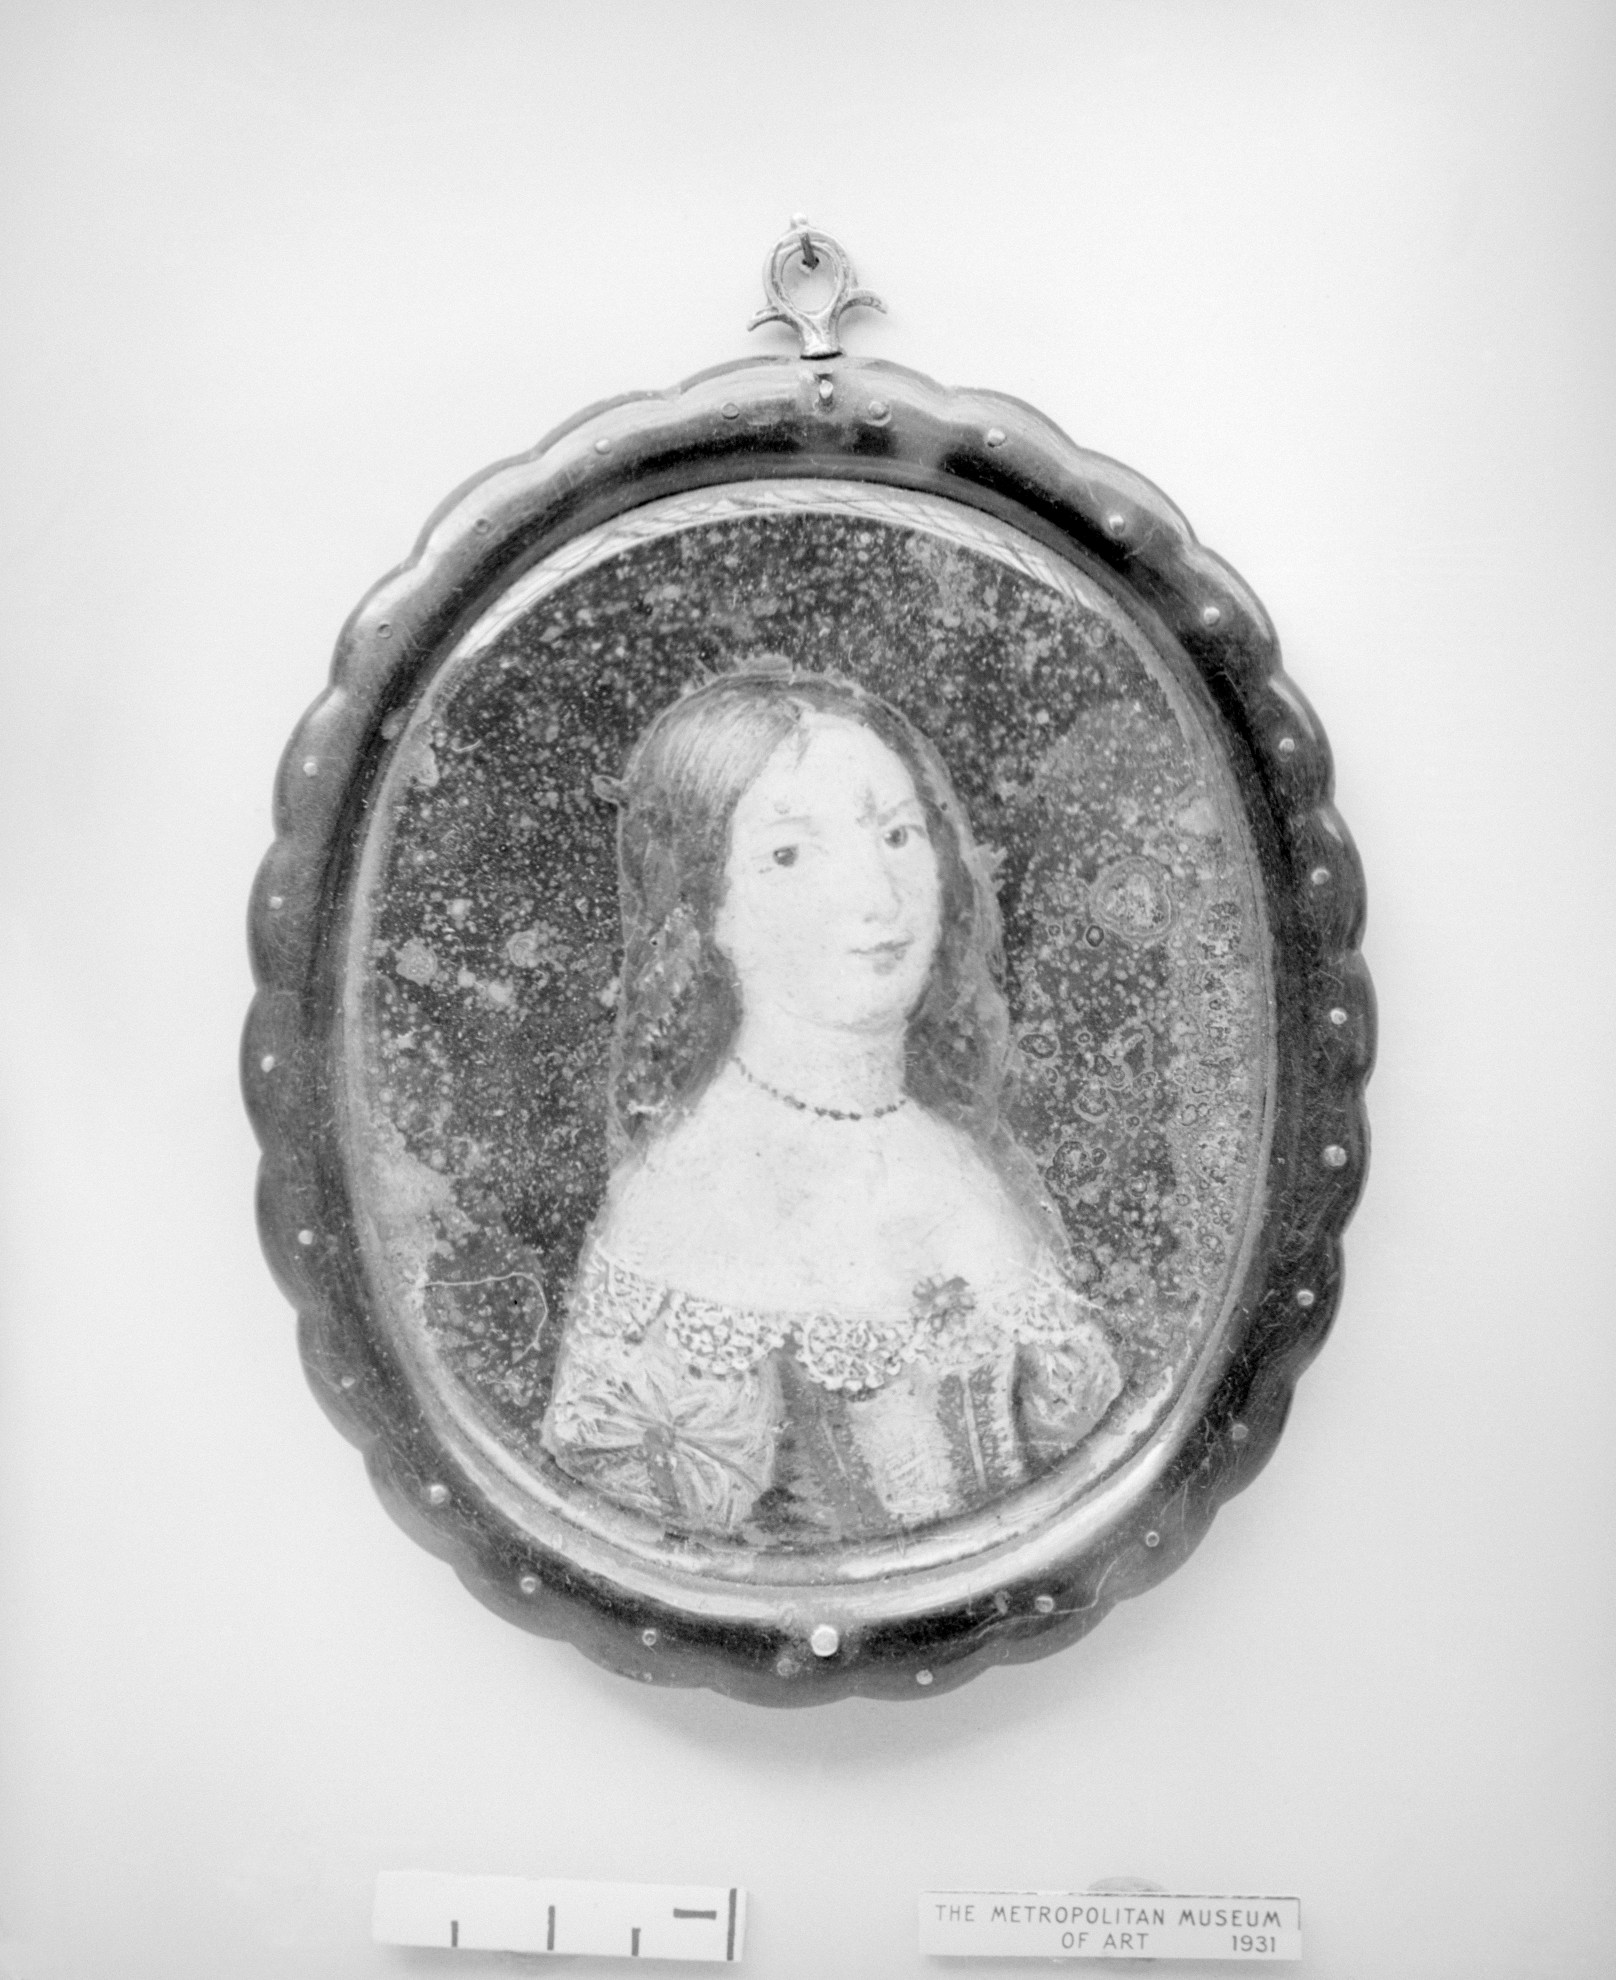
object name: mirror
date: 1650-1700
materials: silver, shell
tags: portraits,women